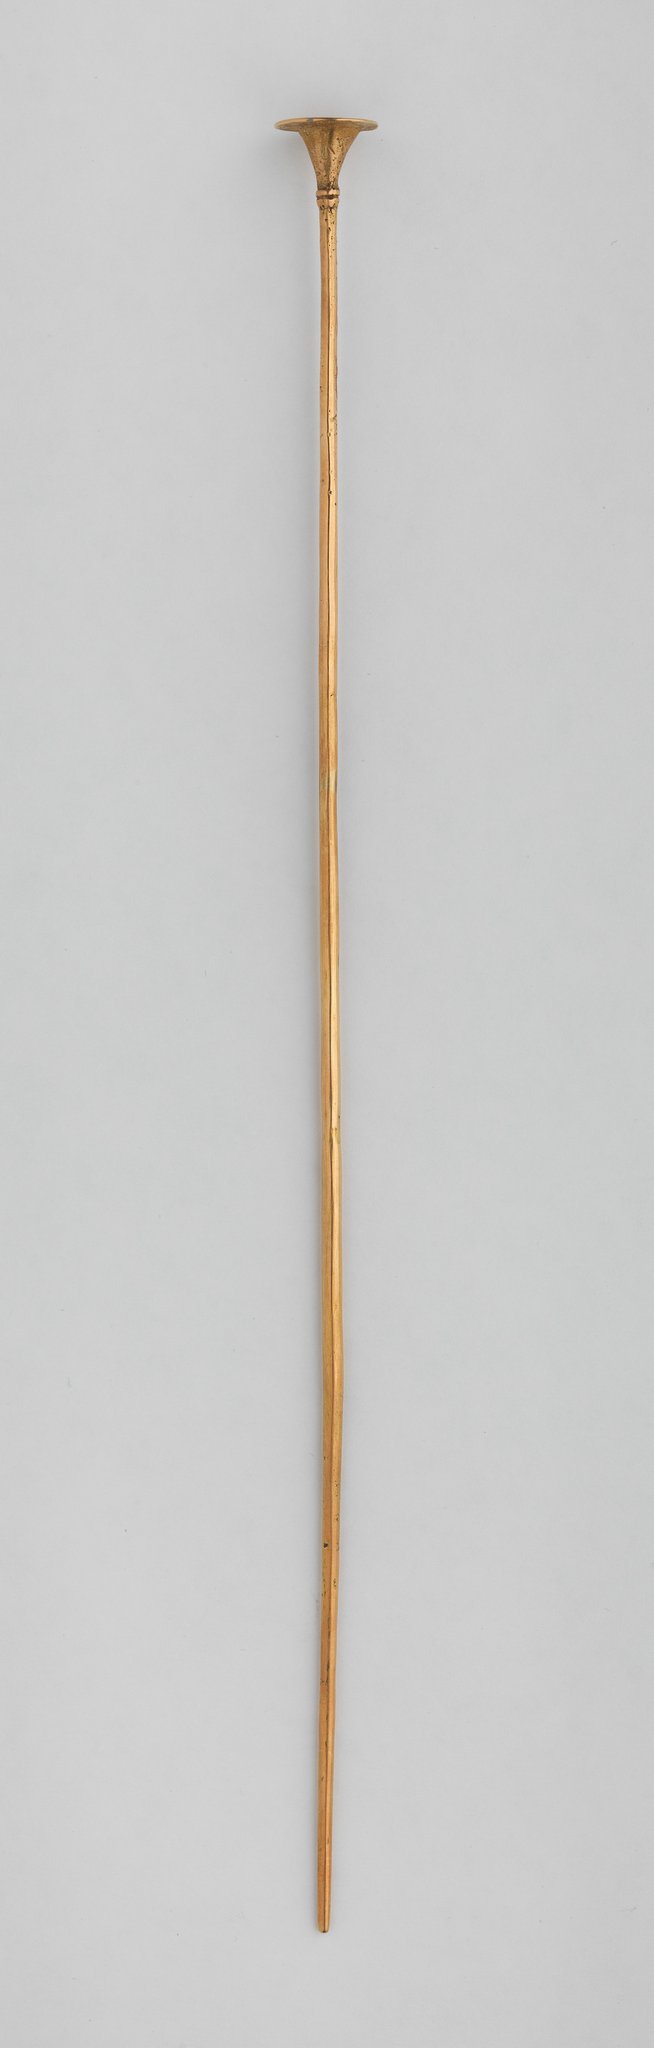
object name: lime dipper or pin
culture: calima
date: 401-1000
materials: gold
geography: colombia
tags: birds